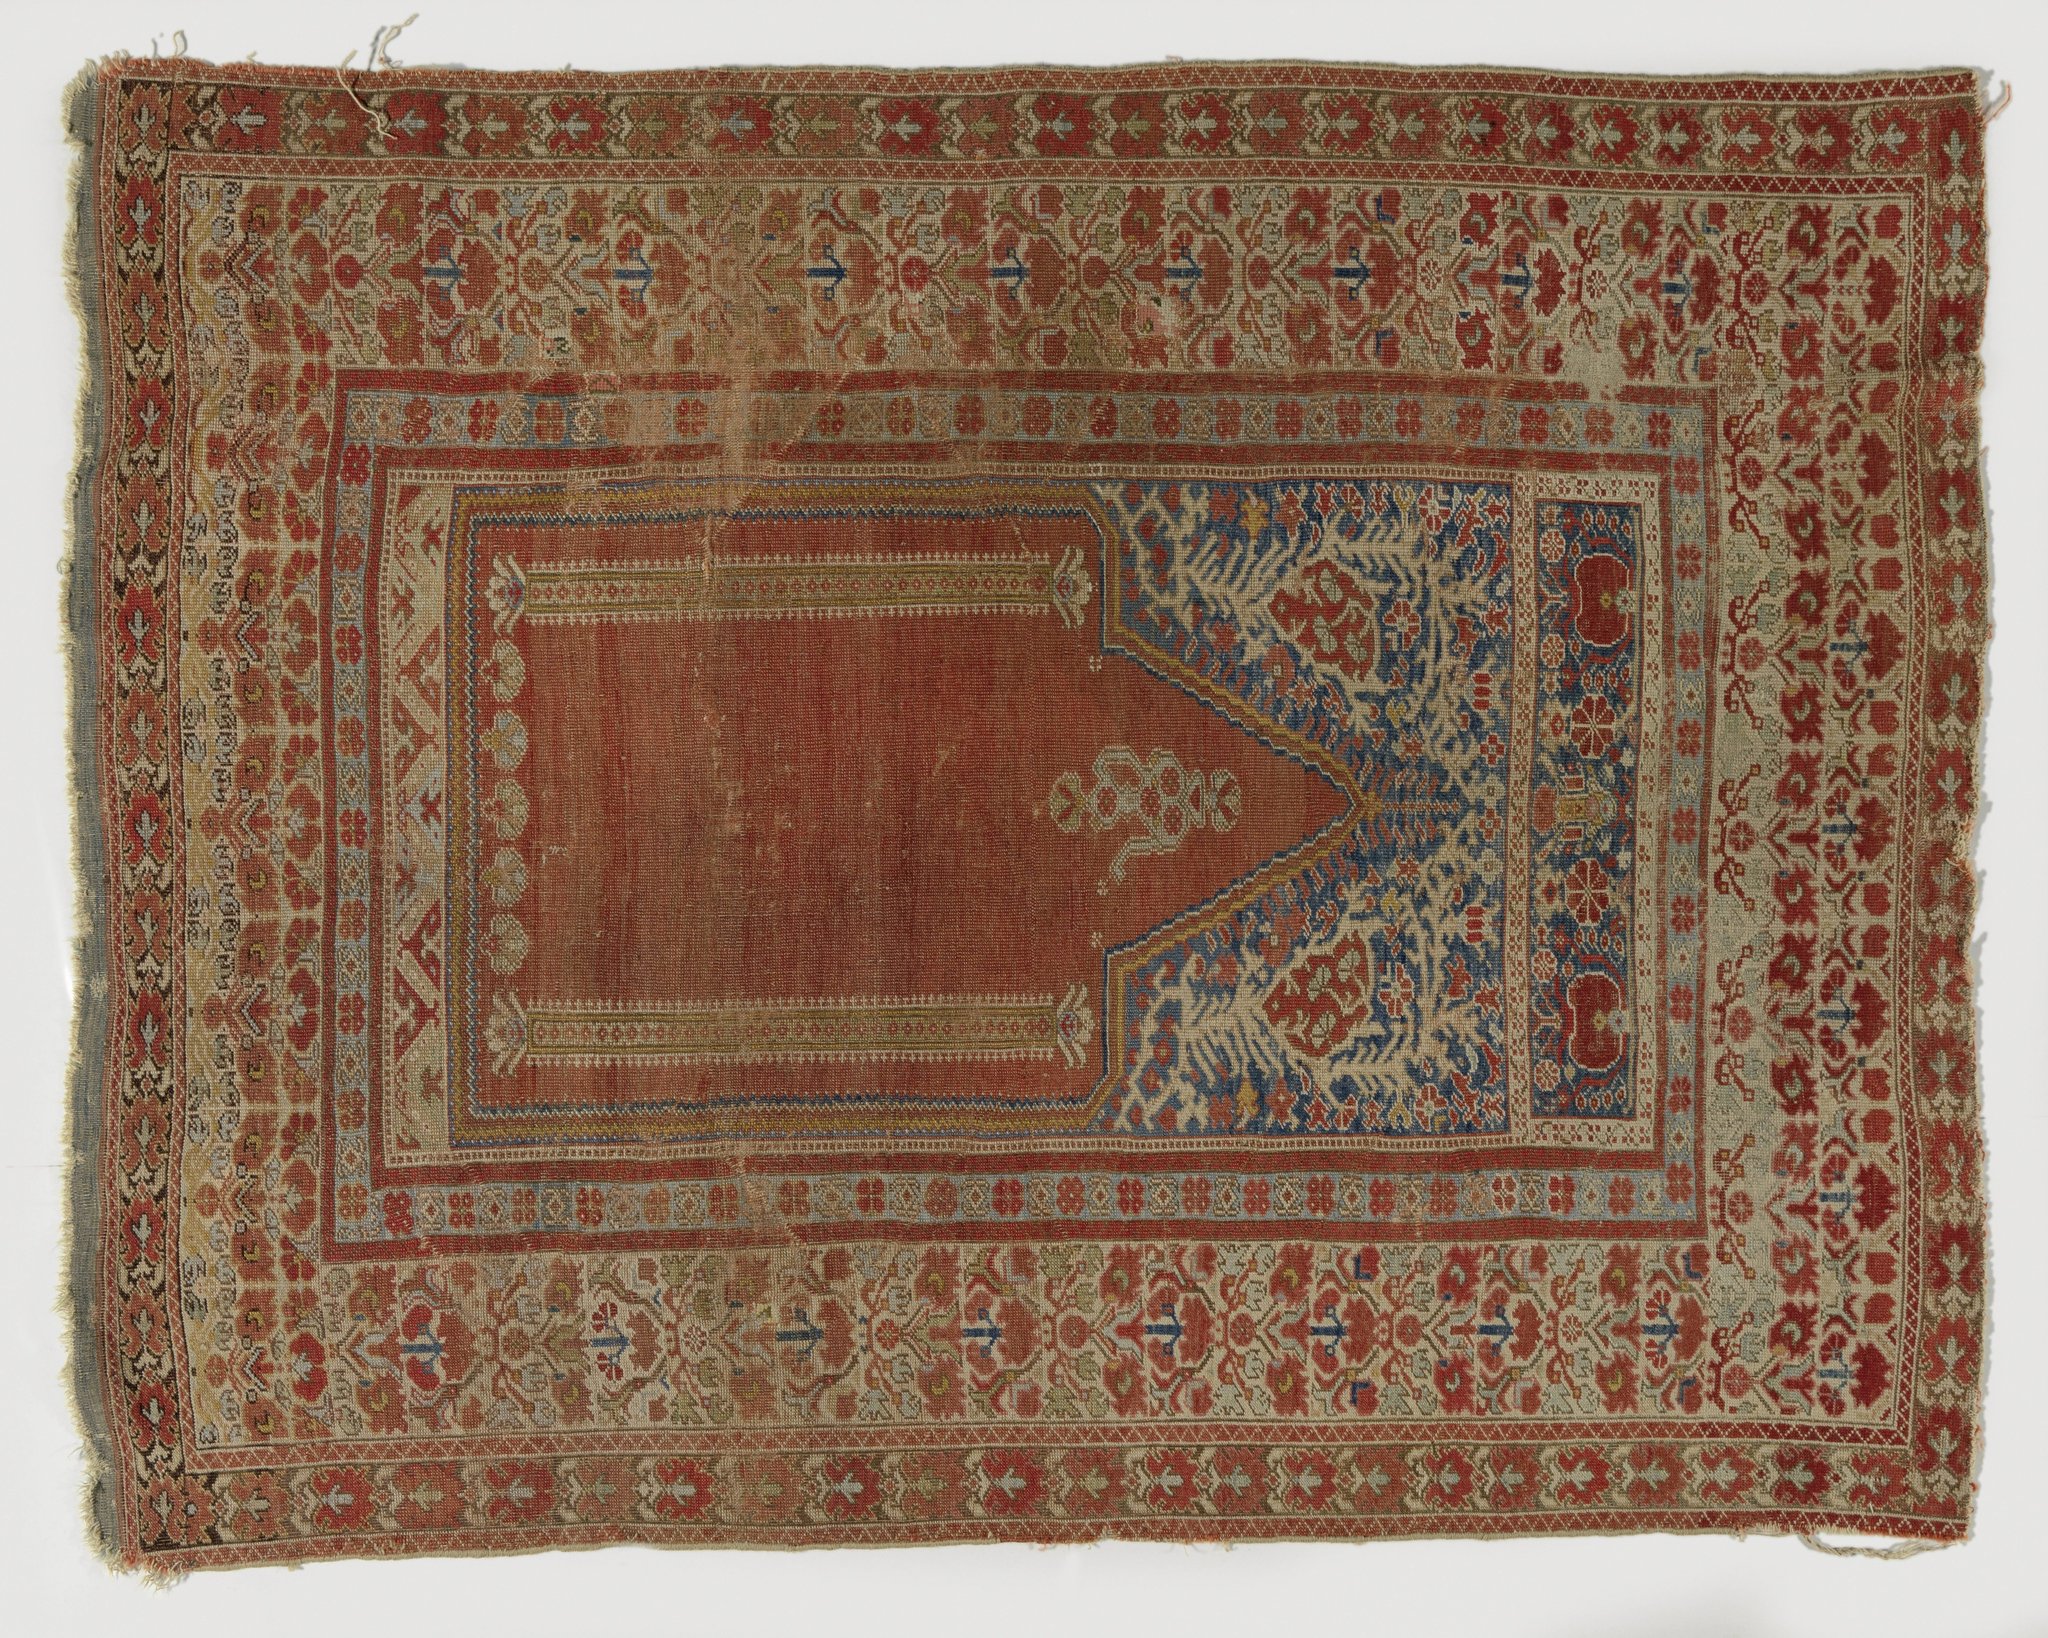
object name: prayer rug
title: Oosters tapijt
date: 1700-1900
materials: wool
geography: ghiordes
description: Oosters tapijt, bidkleed, van geknoopte wol, versierd met een terra-cotta mihrab, geschouderd en met getande top, waarin een omgekeerde oliekan hangt. Helderblauwe zwikken met bloemtakken. Rond het middenveld drie randen en getande tussenzomen.